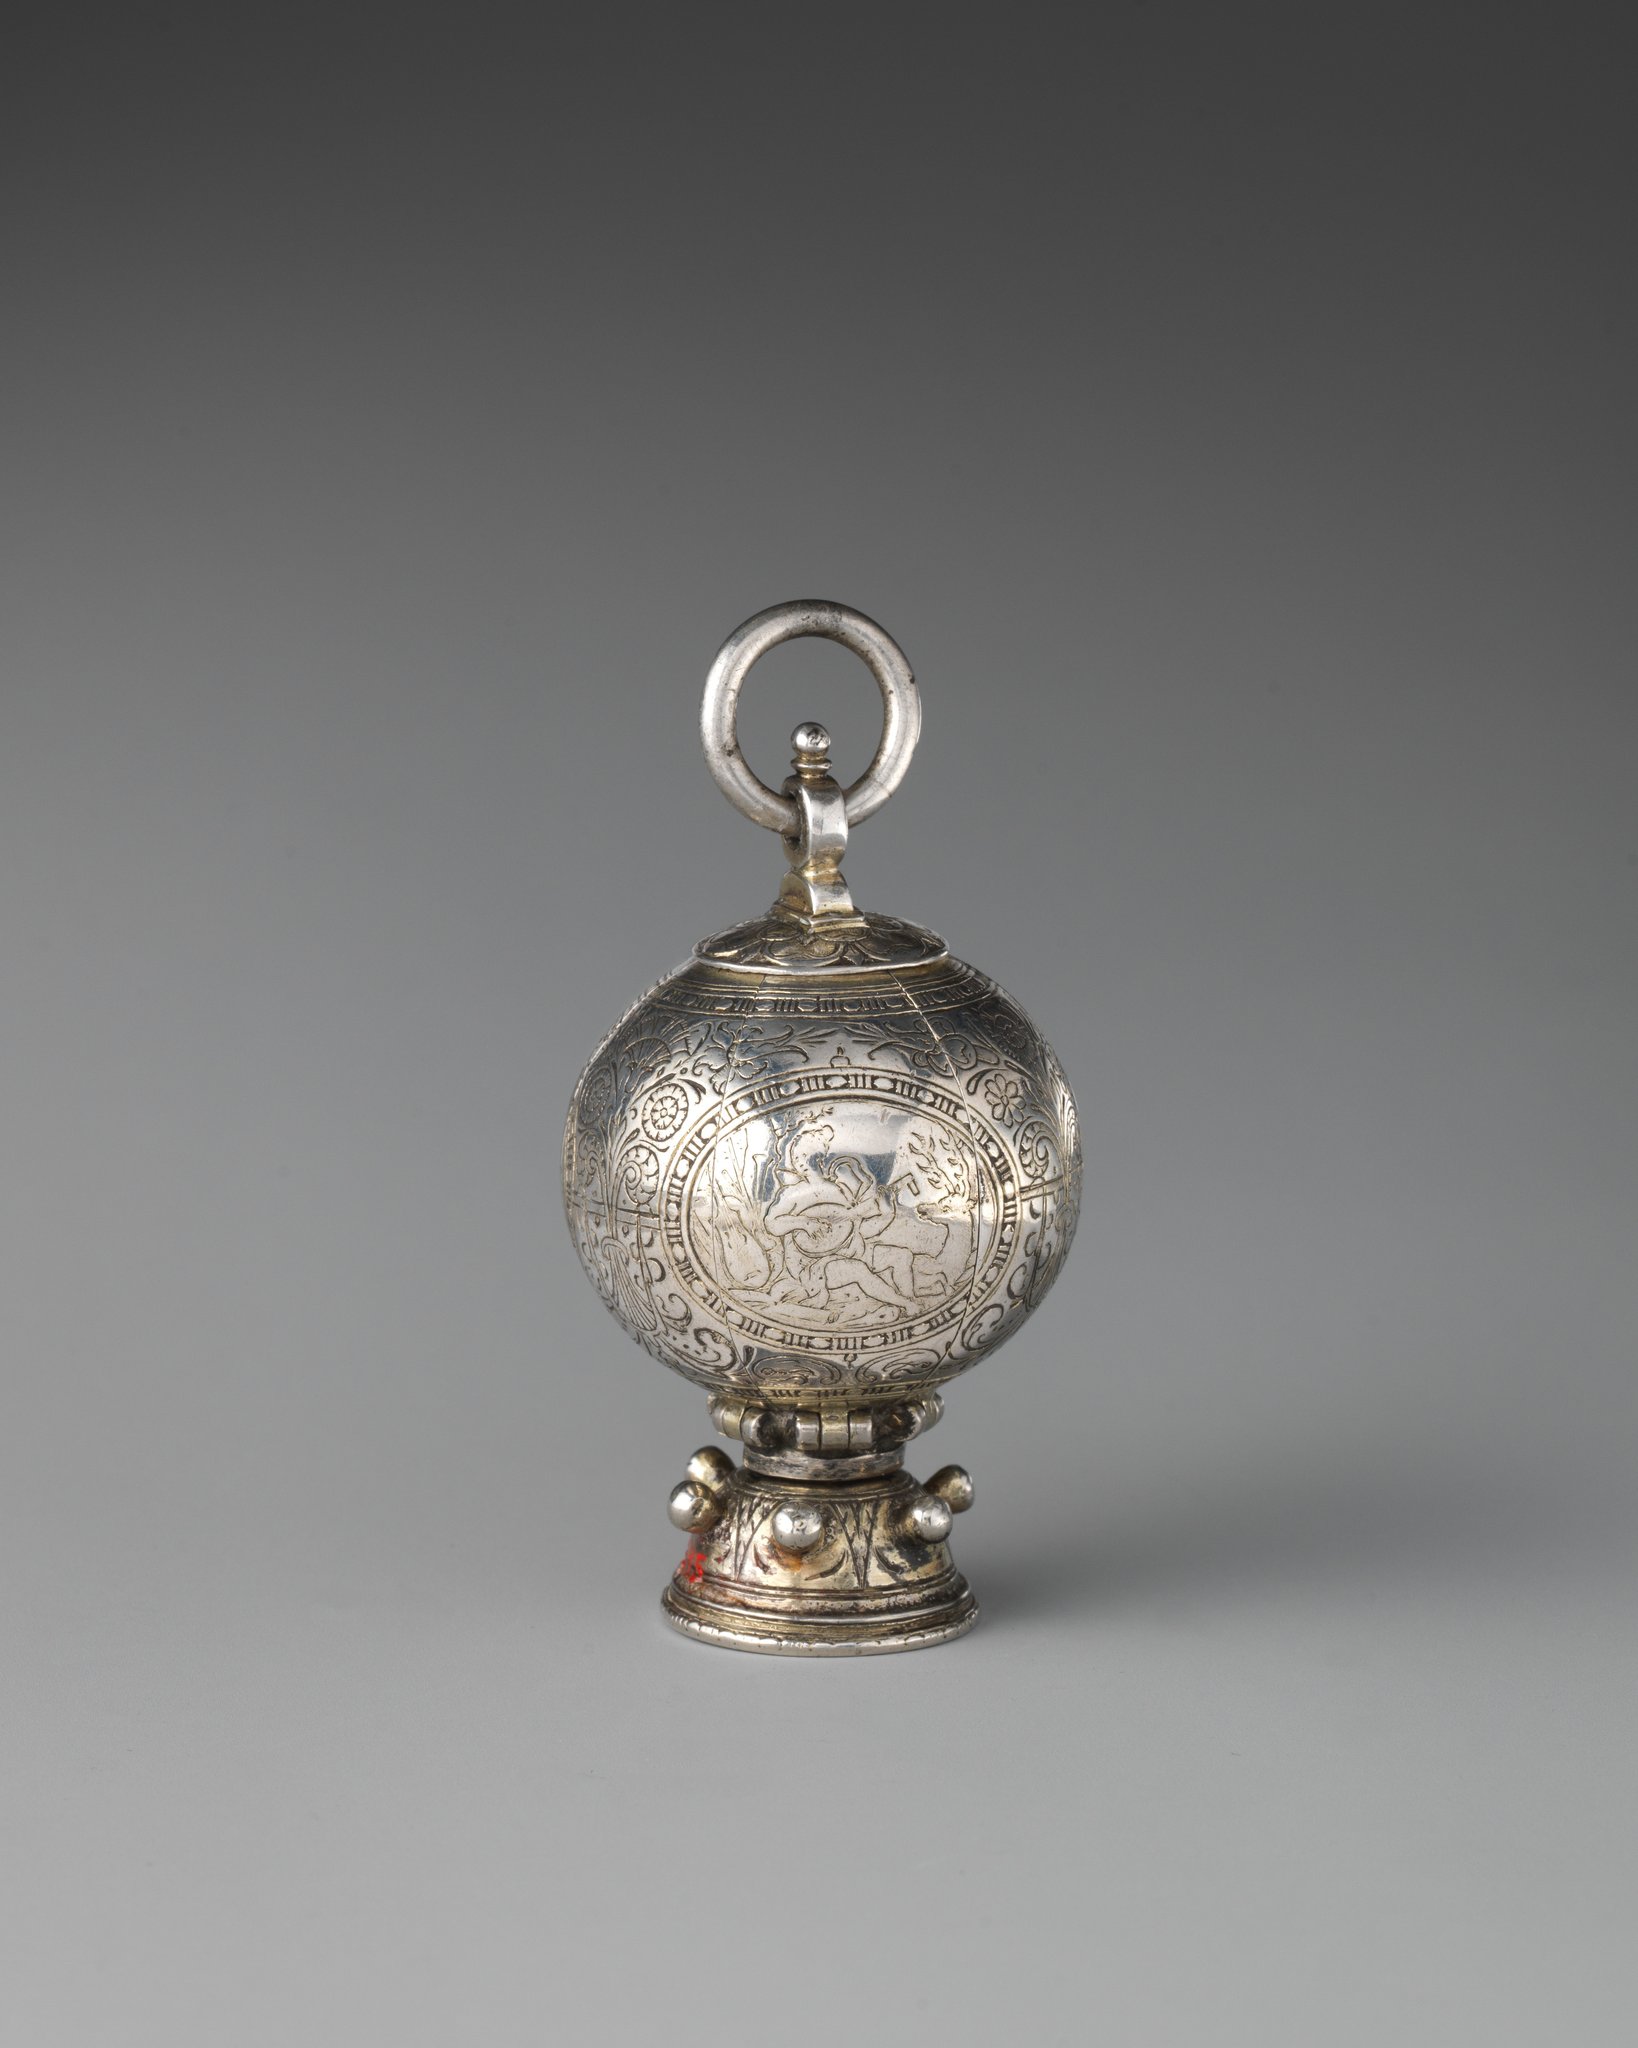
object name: pomander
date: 1501-1600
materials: silver gilt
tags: human figures,musical instruments,flowers